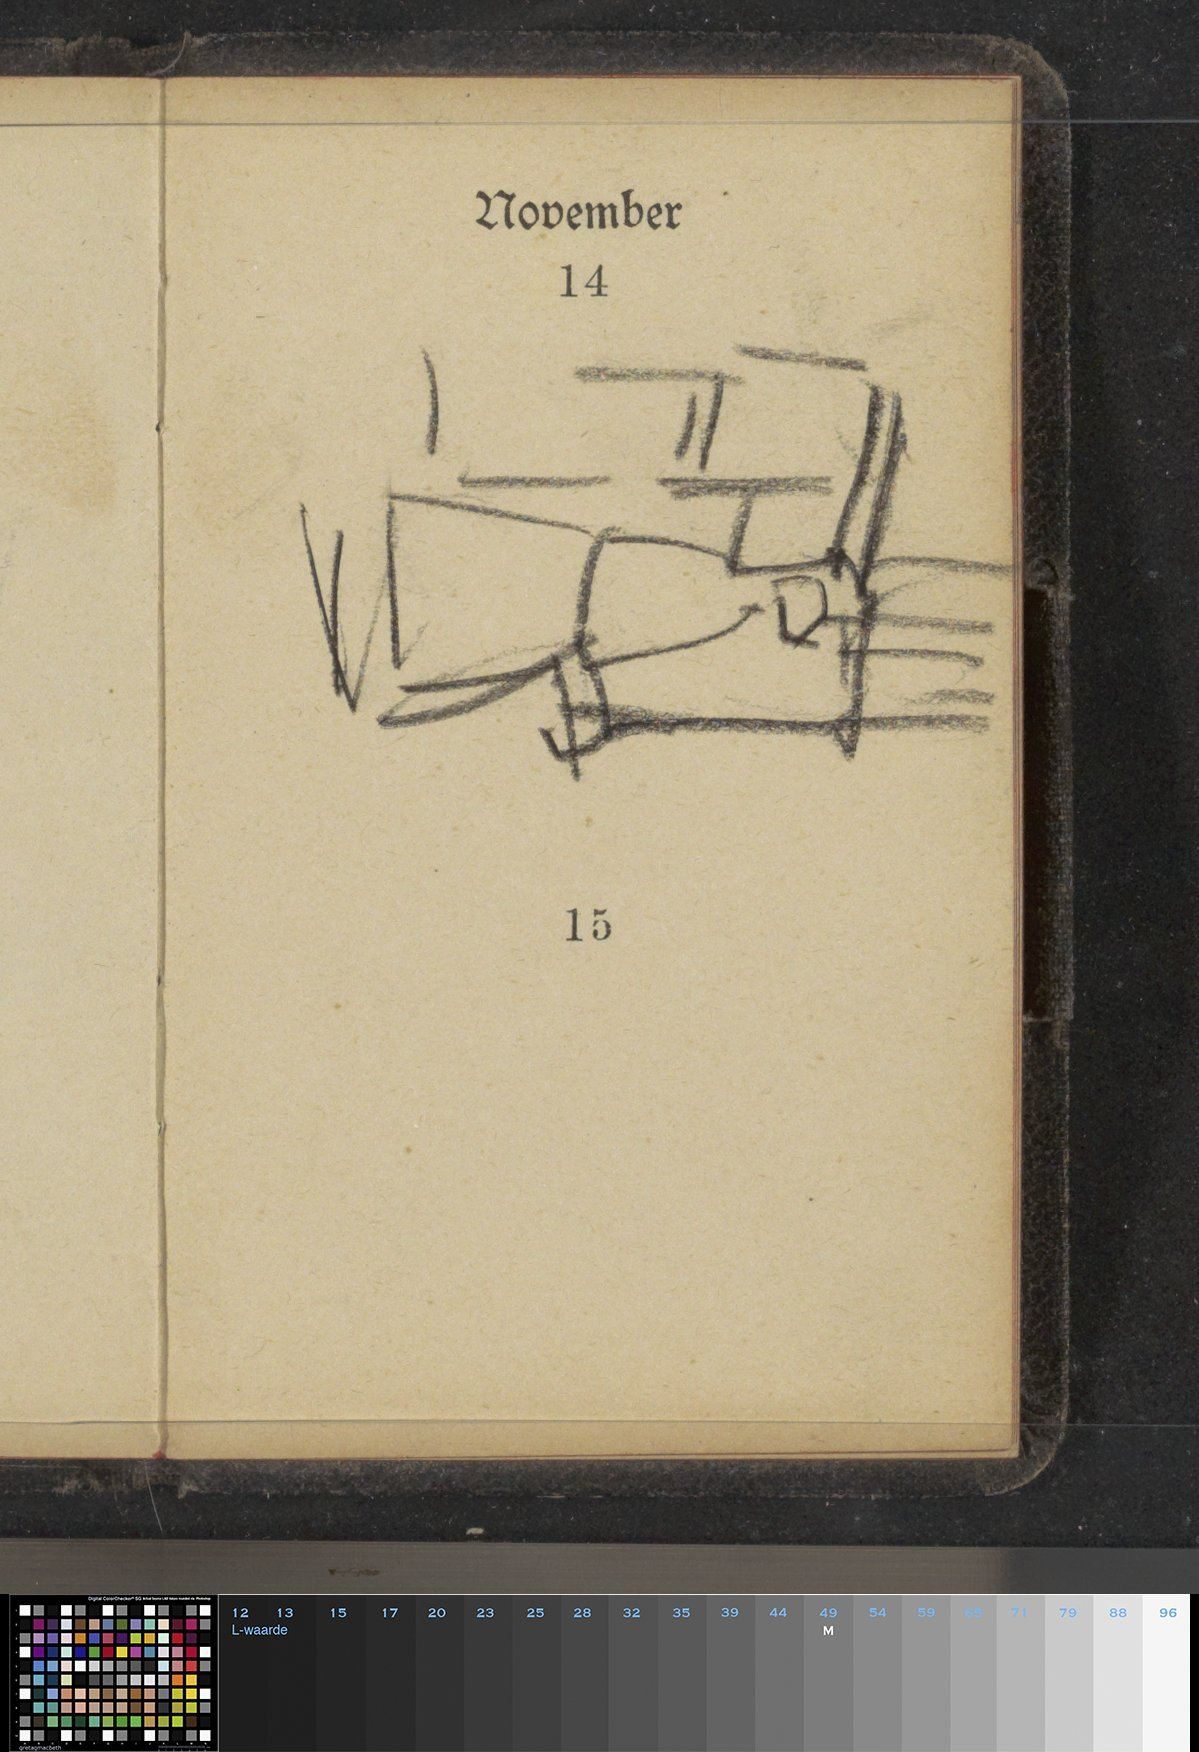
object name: sketchbook leaf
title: Vrouw voor een gebouw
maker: george hendrik breitner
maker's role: draughtsman, painter, print maker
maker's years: 1857-1923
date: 1893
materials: chalk, paper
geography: amsterdam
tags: adult woman, civic architecture; edifices; dwellings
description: Pagina 132 uit een als schetsboek gebruikte agenda met 80 bladen.